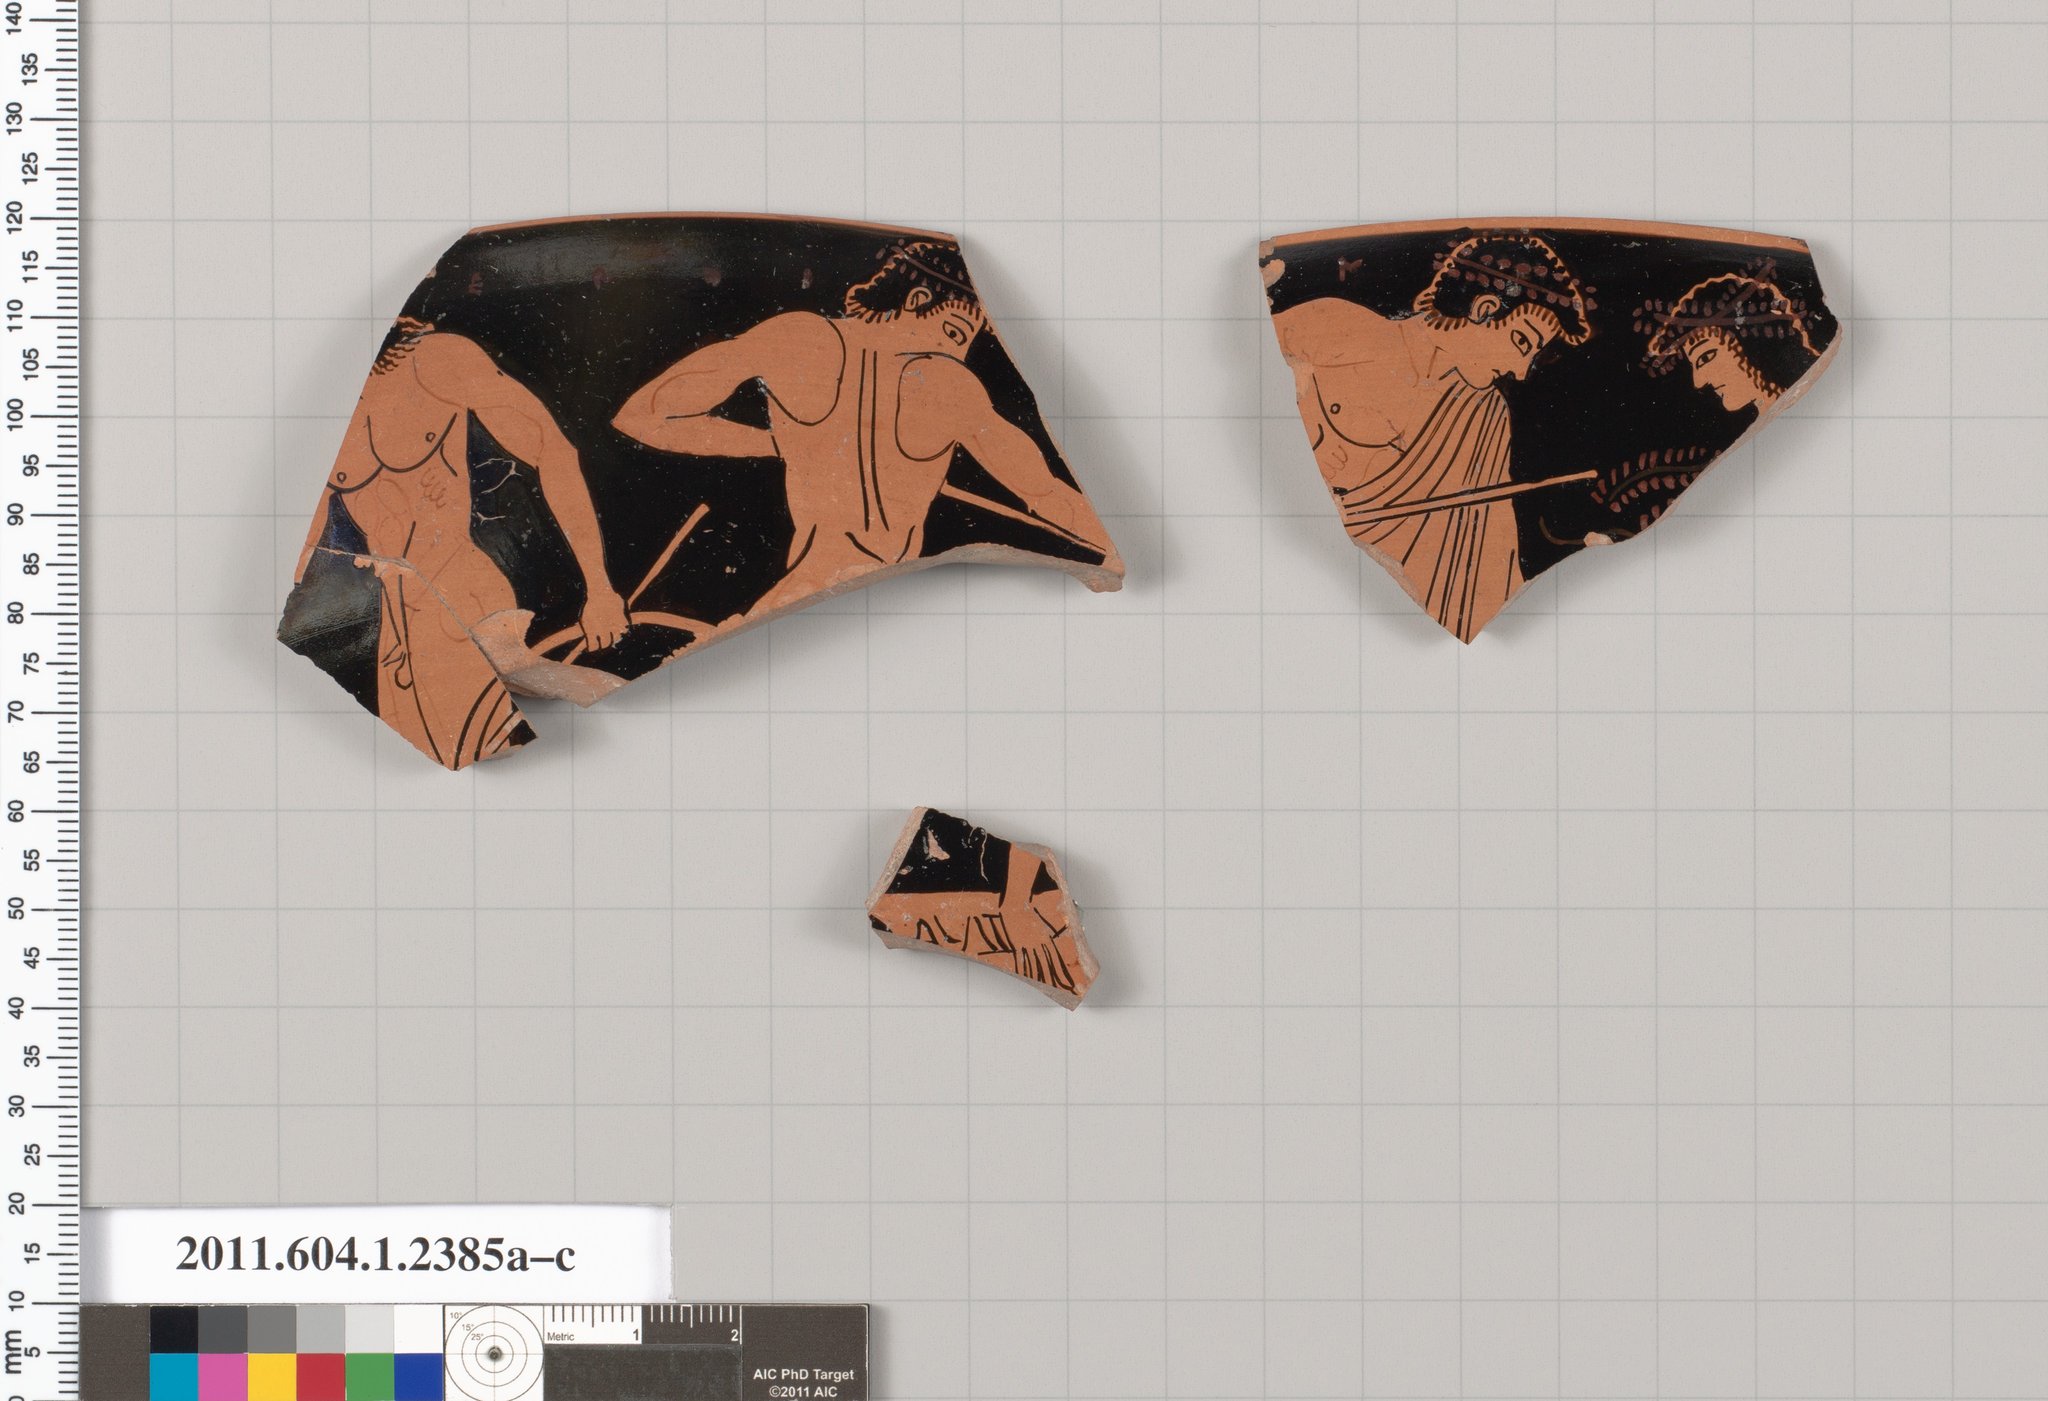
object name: kylix fragment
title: Terracotta fragments of a kylix (drinking cup)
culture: greek, attic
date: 520-500 BCE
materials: terracotta